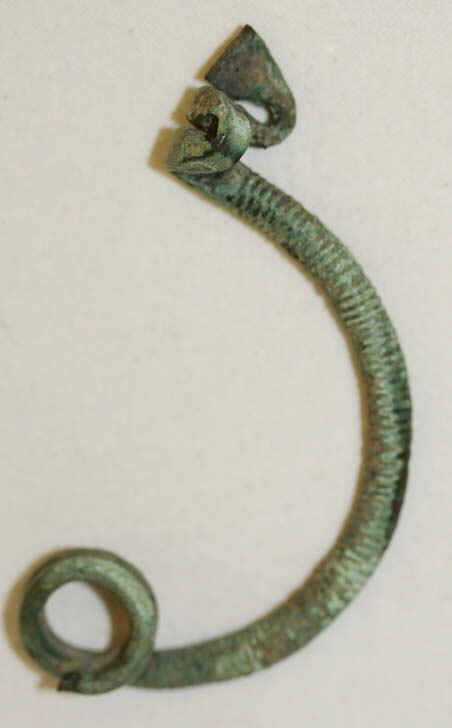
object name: pin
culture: european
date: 400-301 BCE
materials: bronze